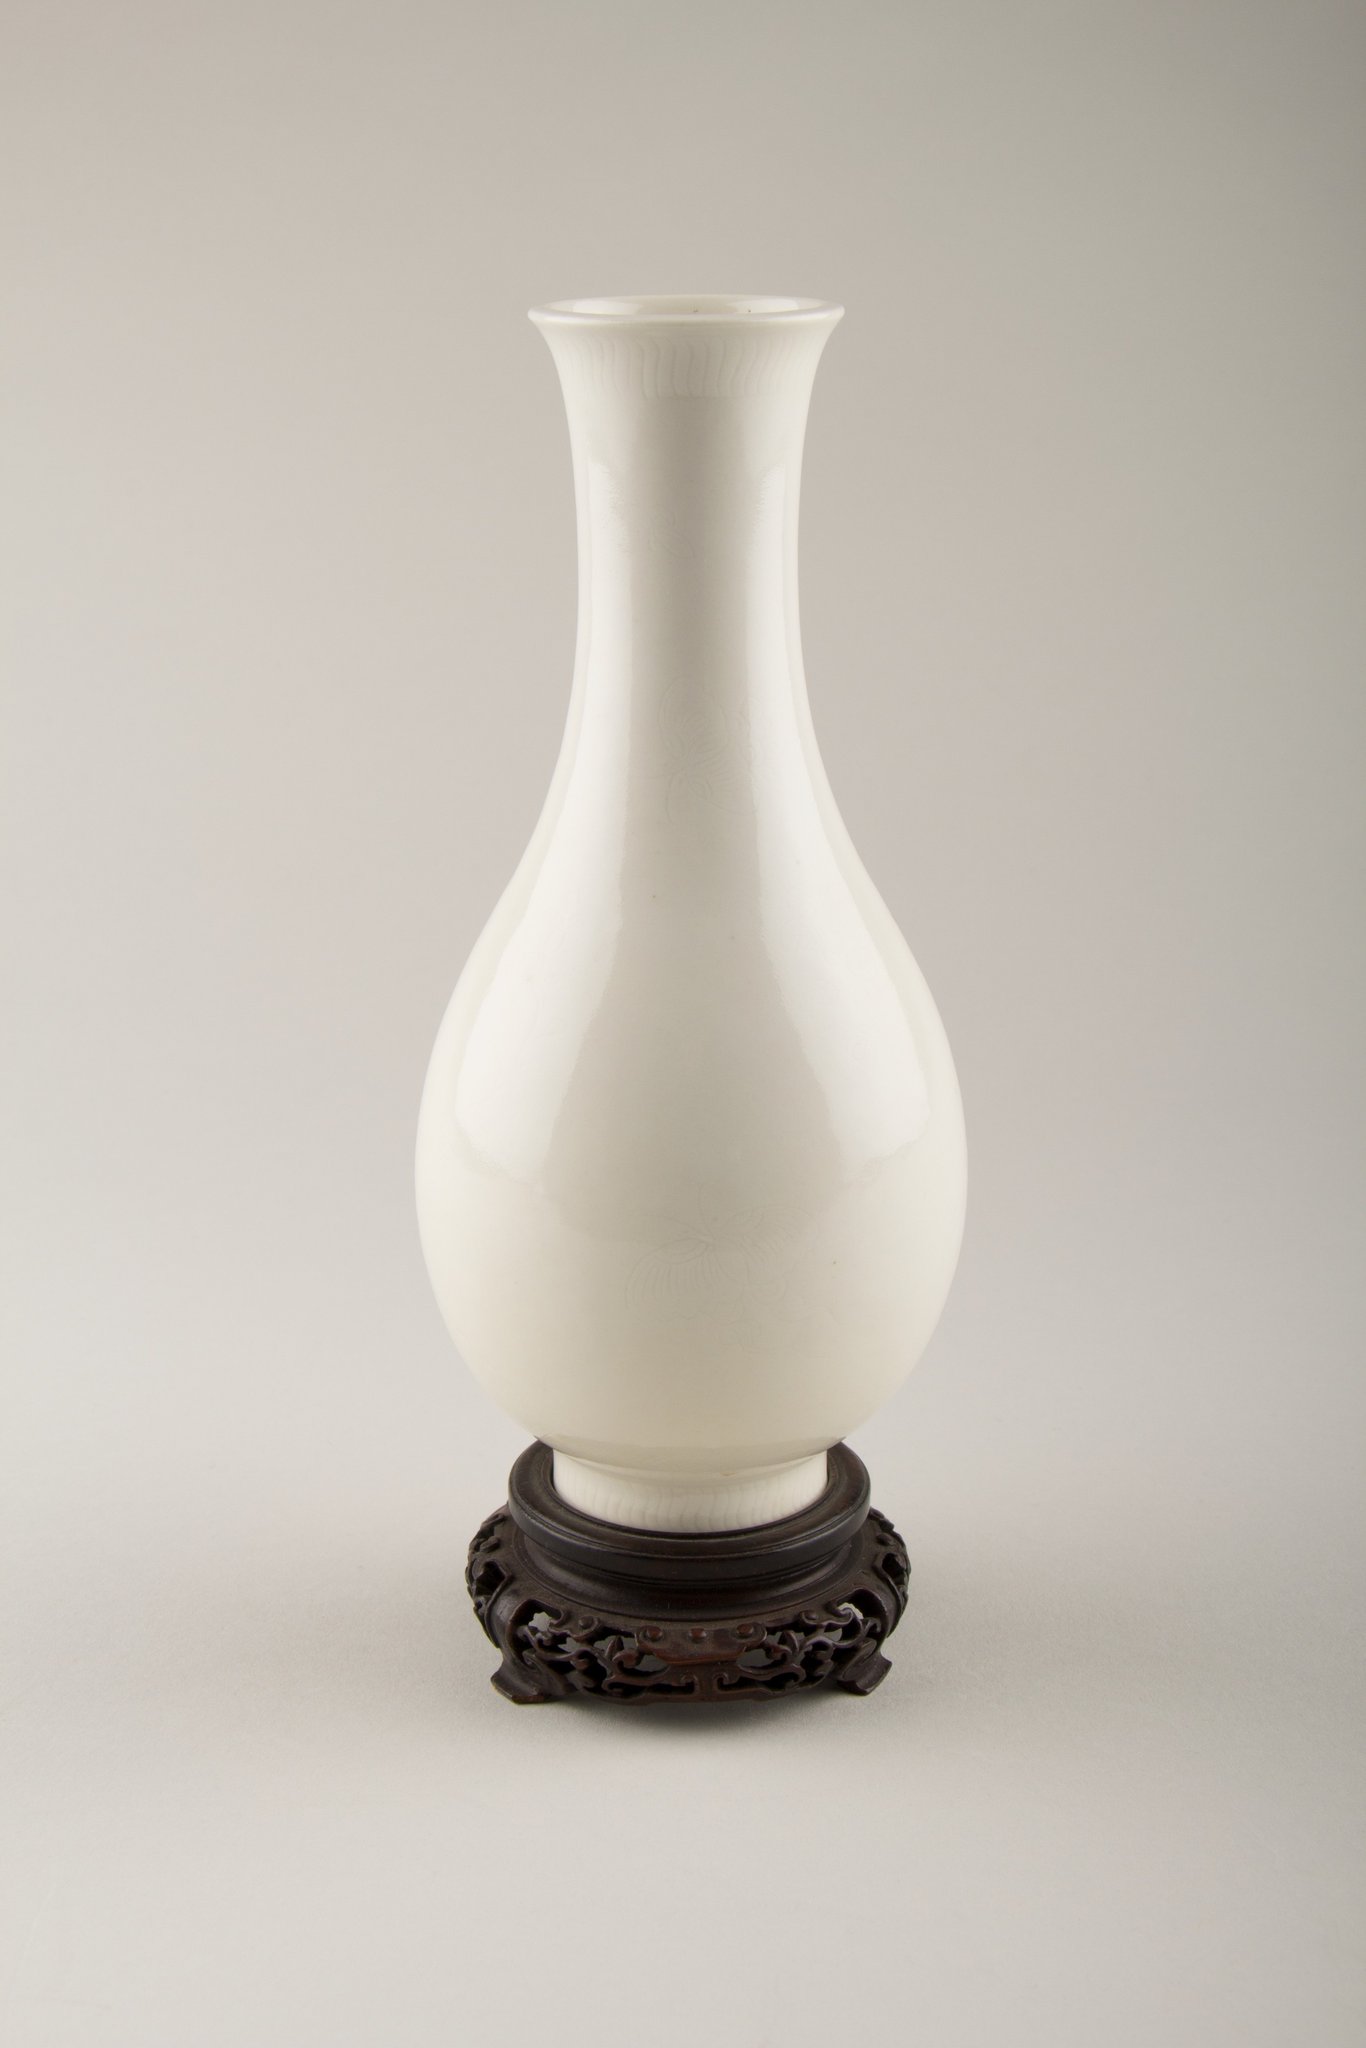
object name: vase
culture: chinese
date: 1723-1735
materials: porcelain